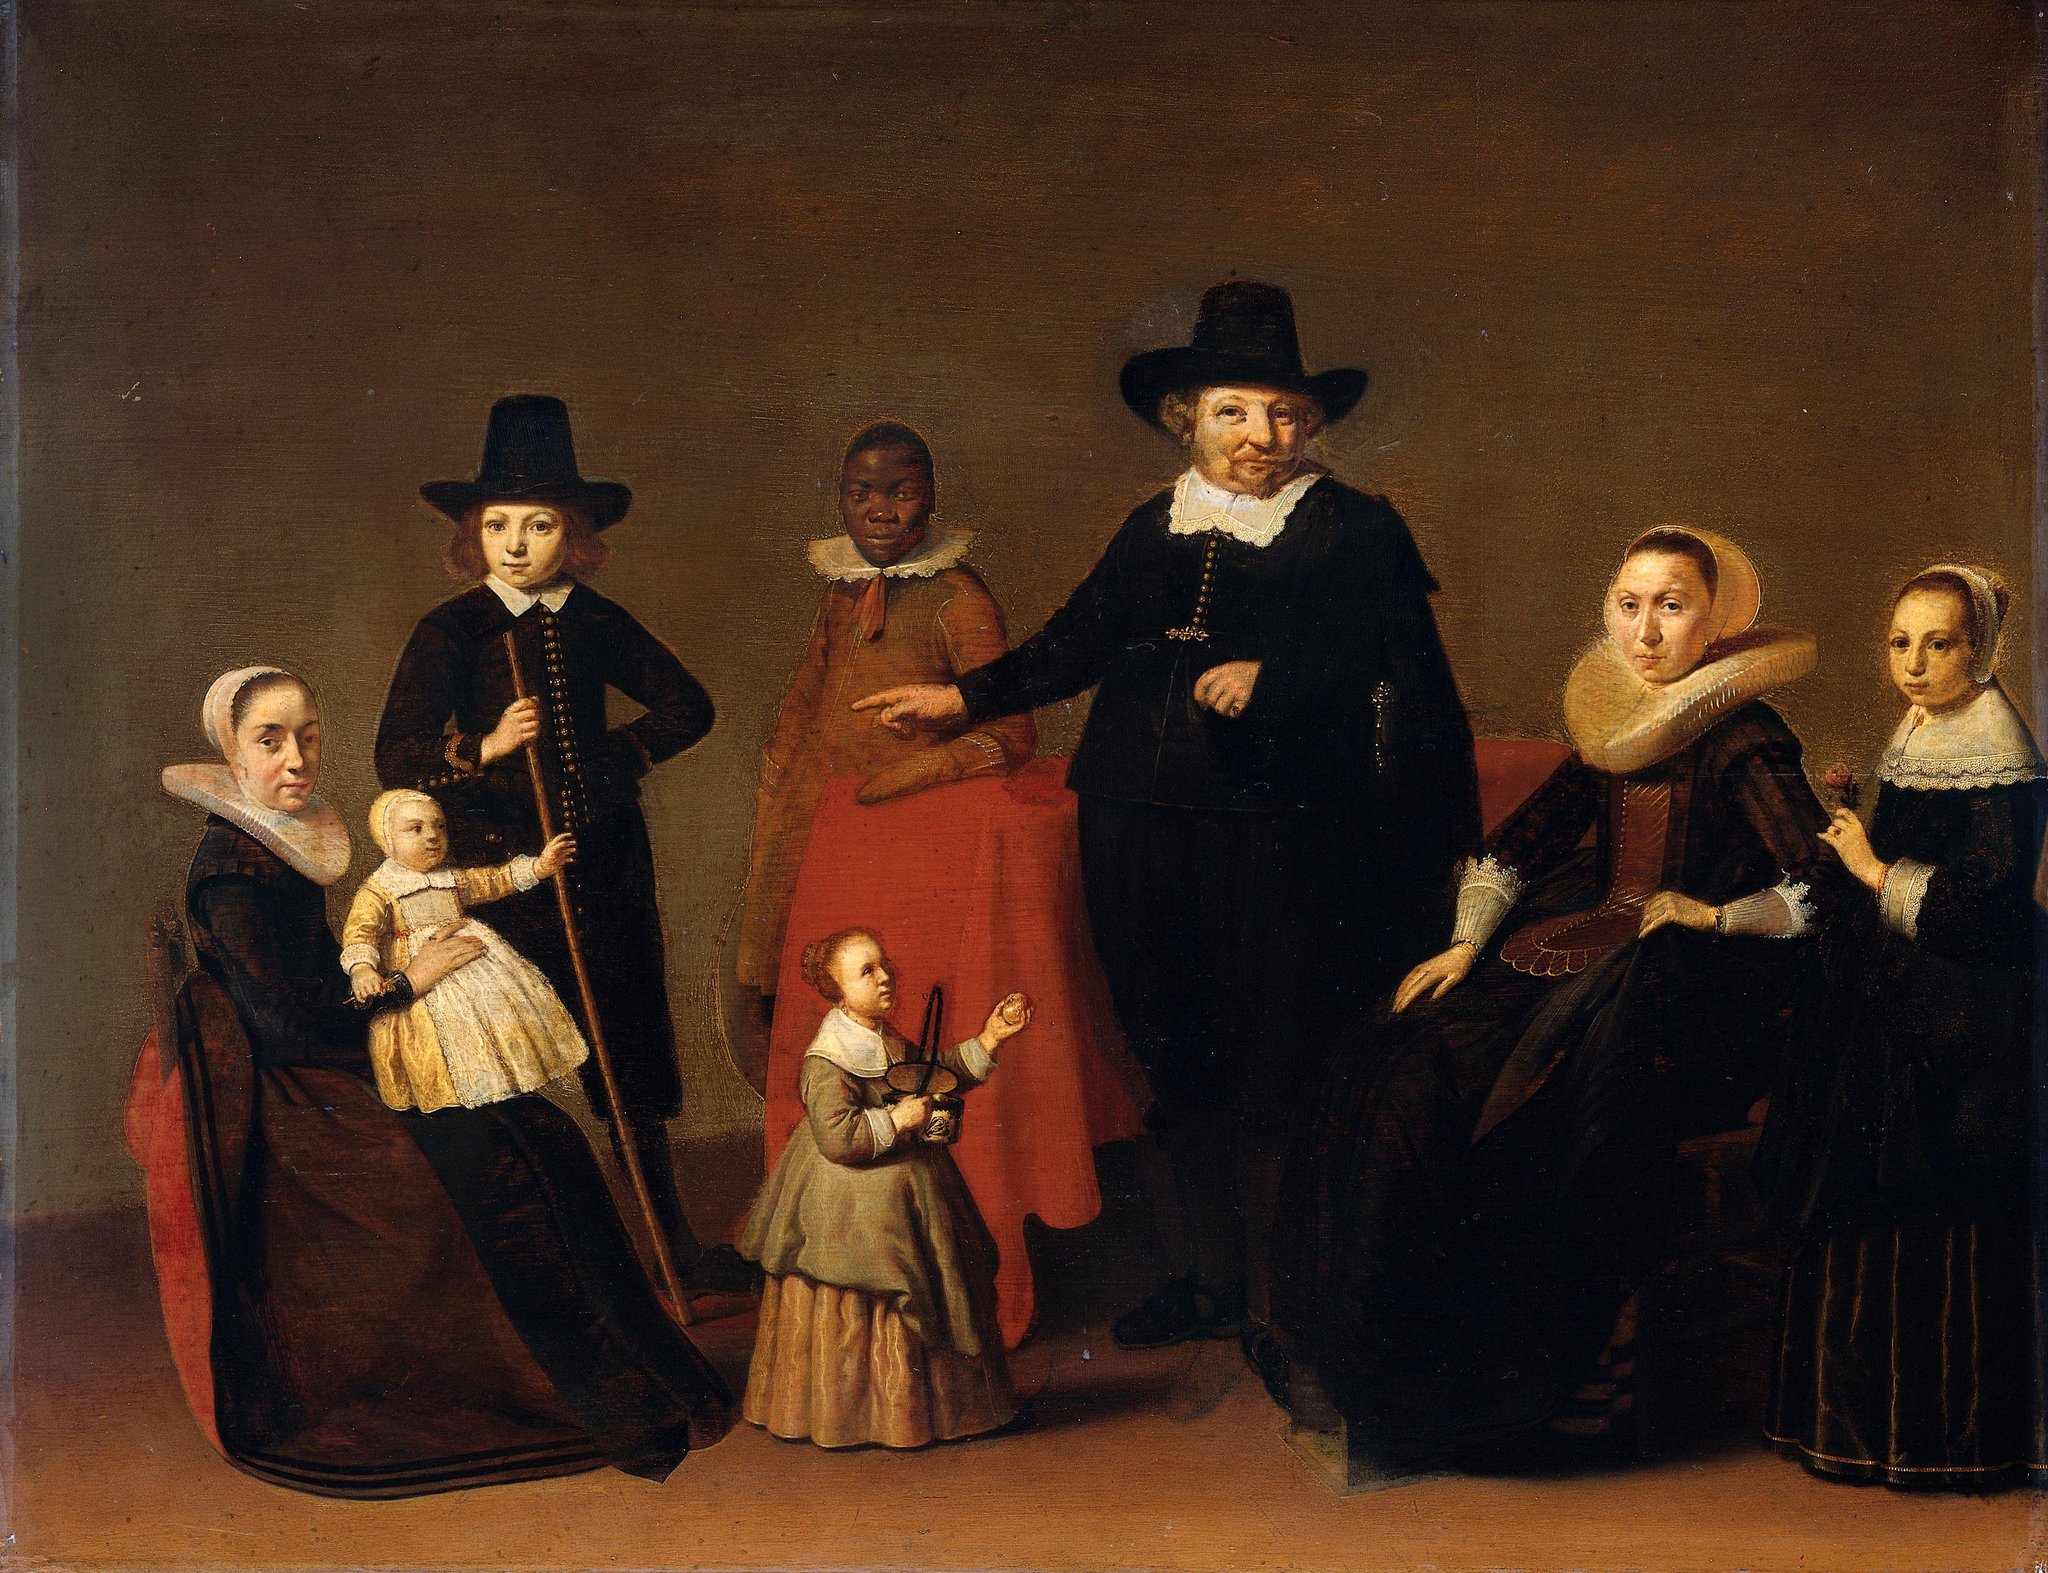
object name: painting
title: Family portrait, possibly the family of Joos Banckert (1599-1647)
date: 1631-1650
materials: oil, paint, panel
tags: africans, house personnel, servants, anonymous historical persons portrayed in a group, in a group-portrait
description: Joost van Trappen met zijn familie en een Afrikaanse huisslaaf. Anoniem, ca. 1635. Veel Zeeuwse kooplieden en zeevarenden waren betrokken bij de kaapvaart en slavenhandel in het Atlantisch gebied. Joost van Trappen (1599-1647), ook Joost Banckert genoemd, nam als vice-admiraal onder bevel van Piet Heyn deel aan de verovering van de Spaanse zilvervloot in 1628. Een jaar later nam hij deel aan de verovering van de stad Recife aan de noordoostkust van Brazilië.